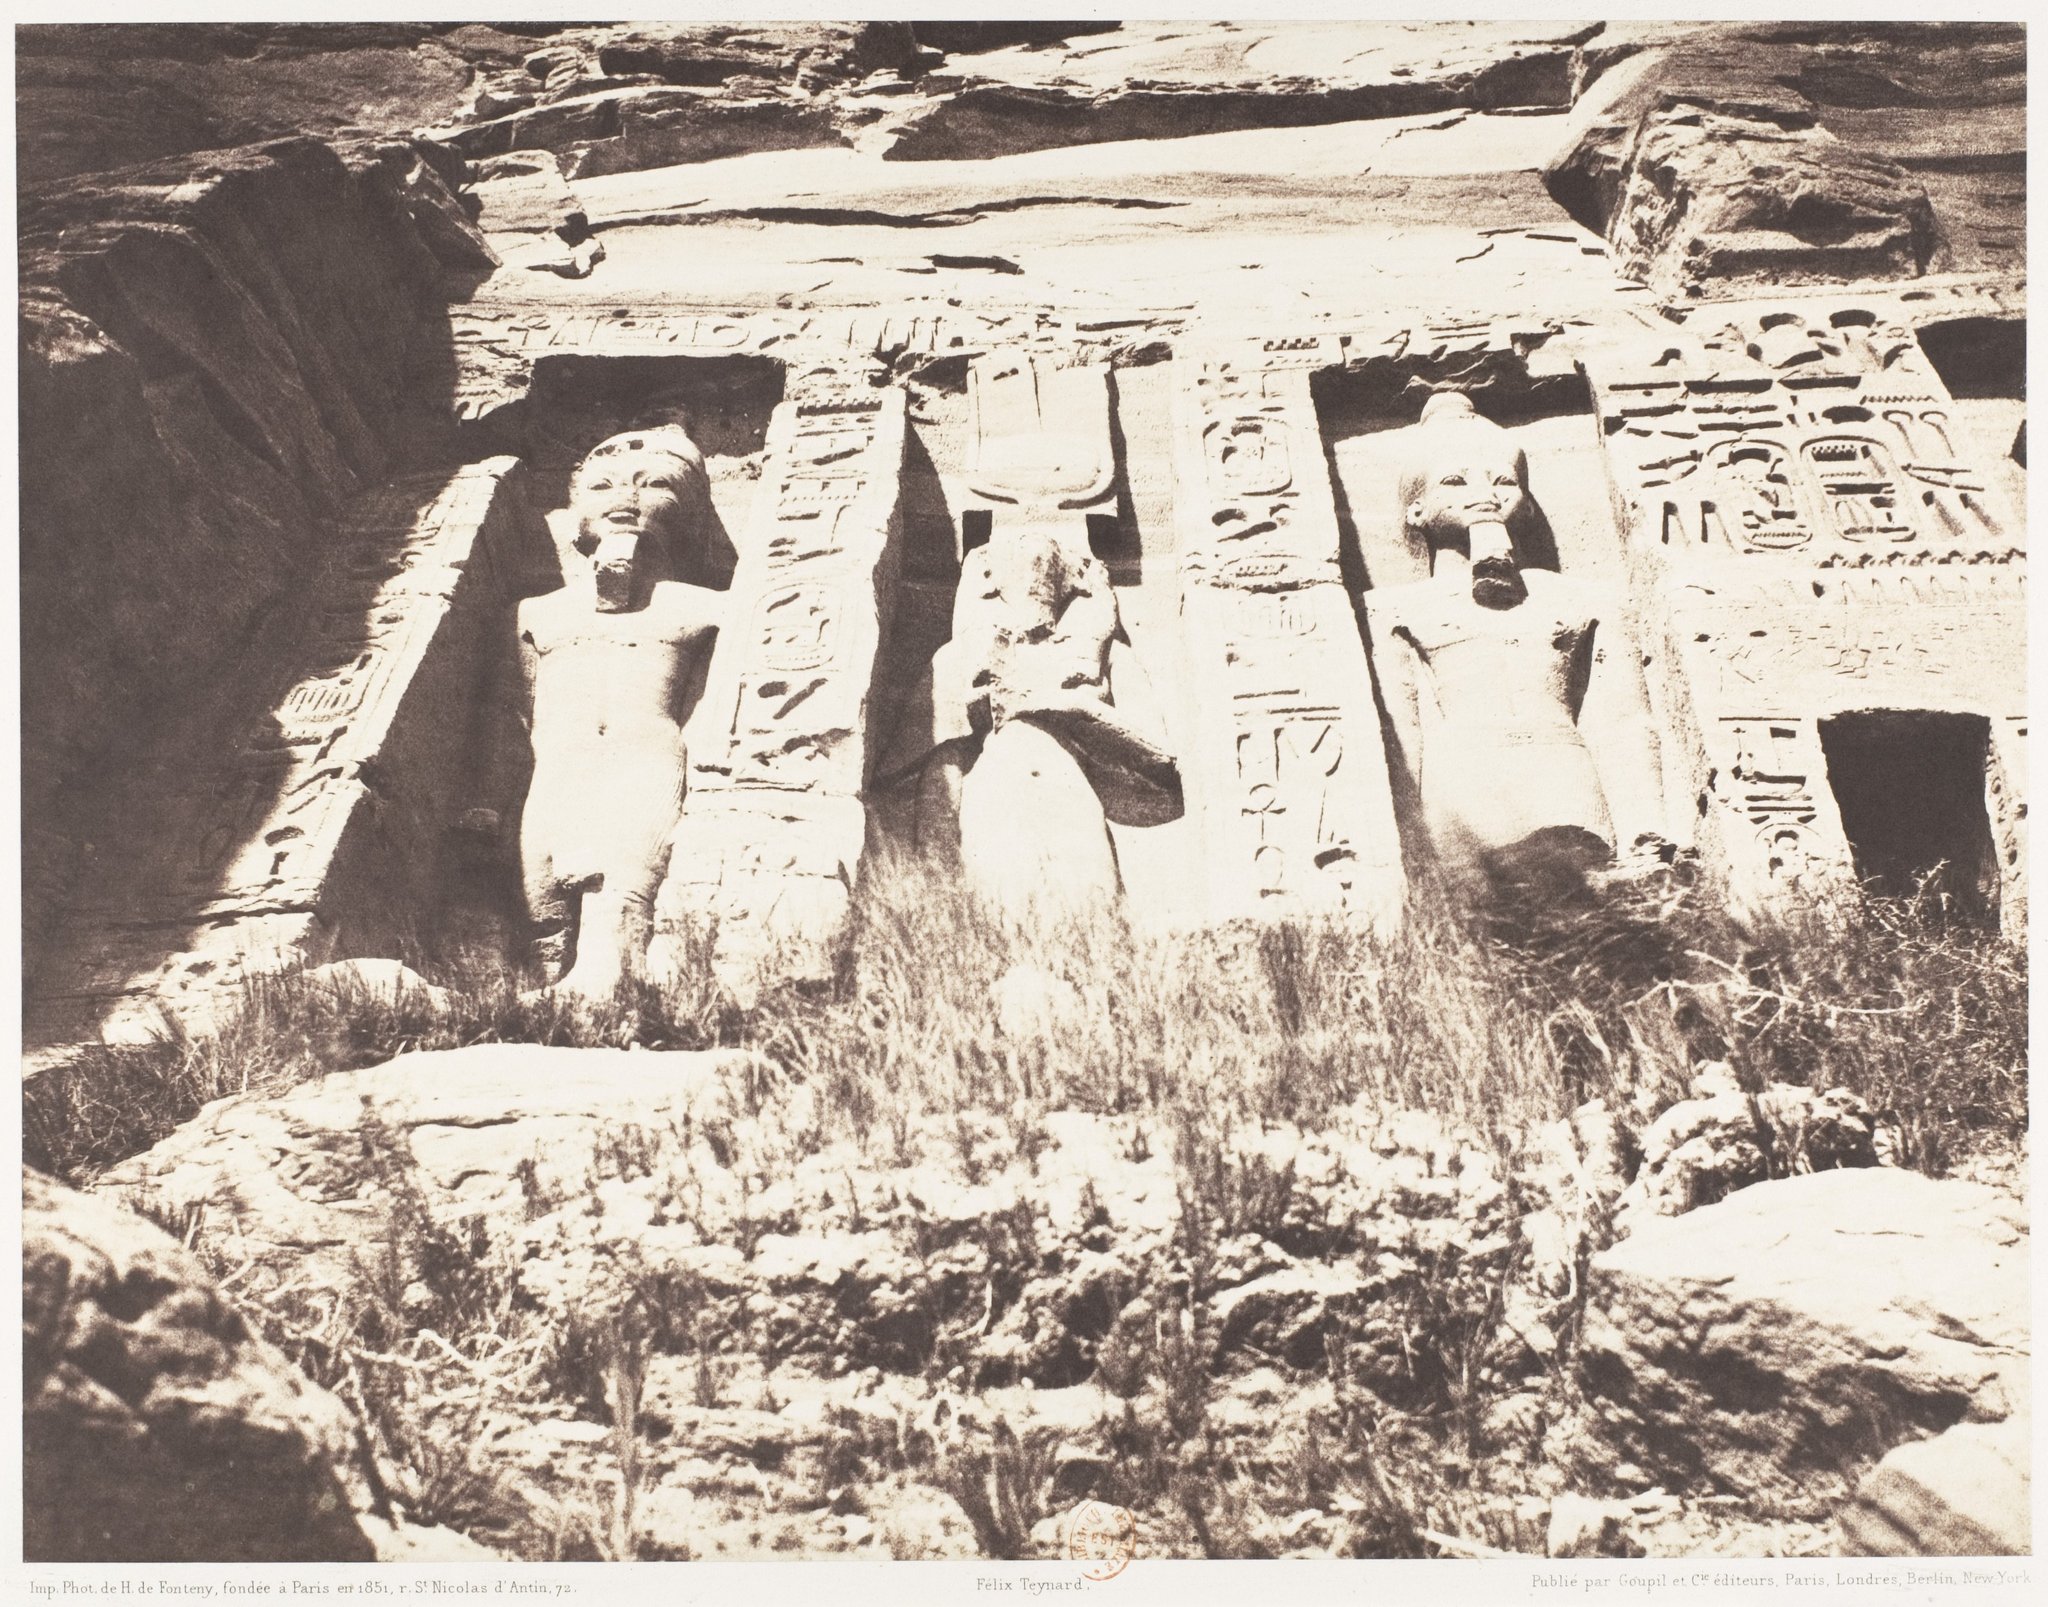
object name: photograph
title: Abou-Sembil, Petit Spéos - Partie Gauche de la Façade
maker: félix teynard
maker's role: artist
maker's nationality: french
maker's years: 1817-1892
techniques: paper negative, salted paper print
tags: architecture,ruins